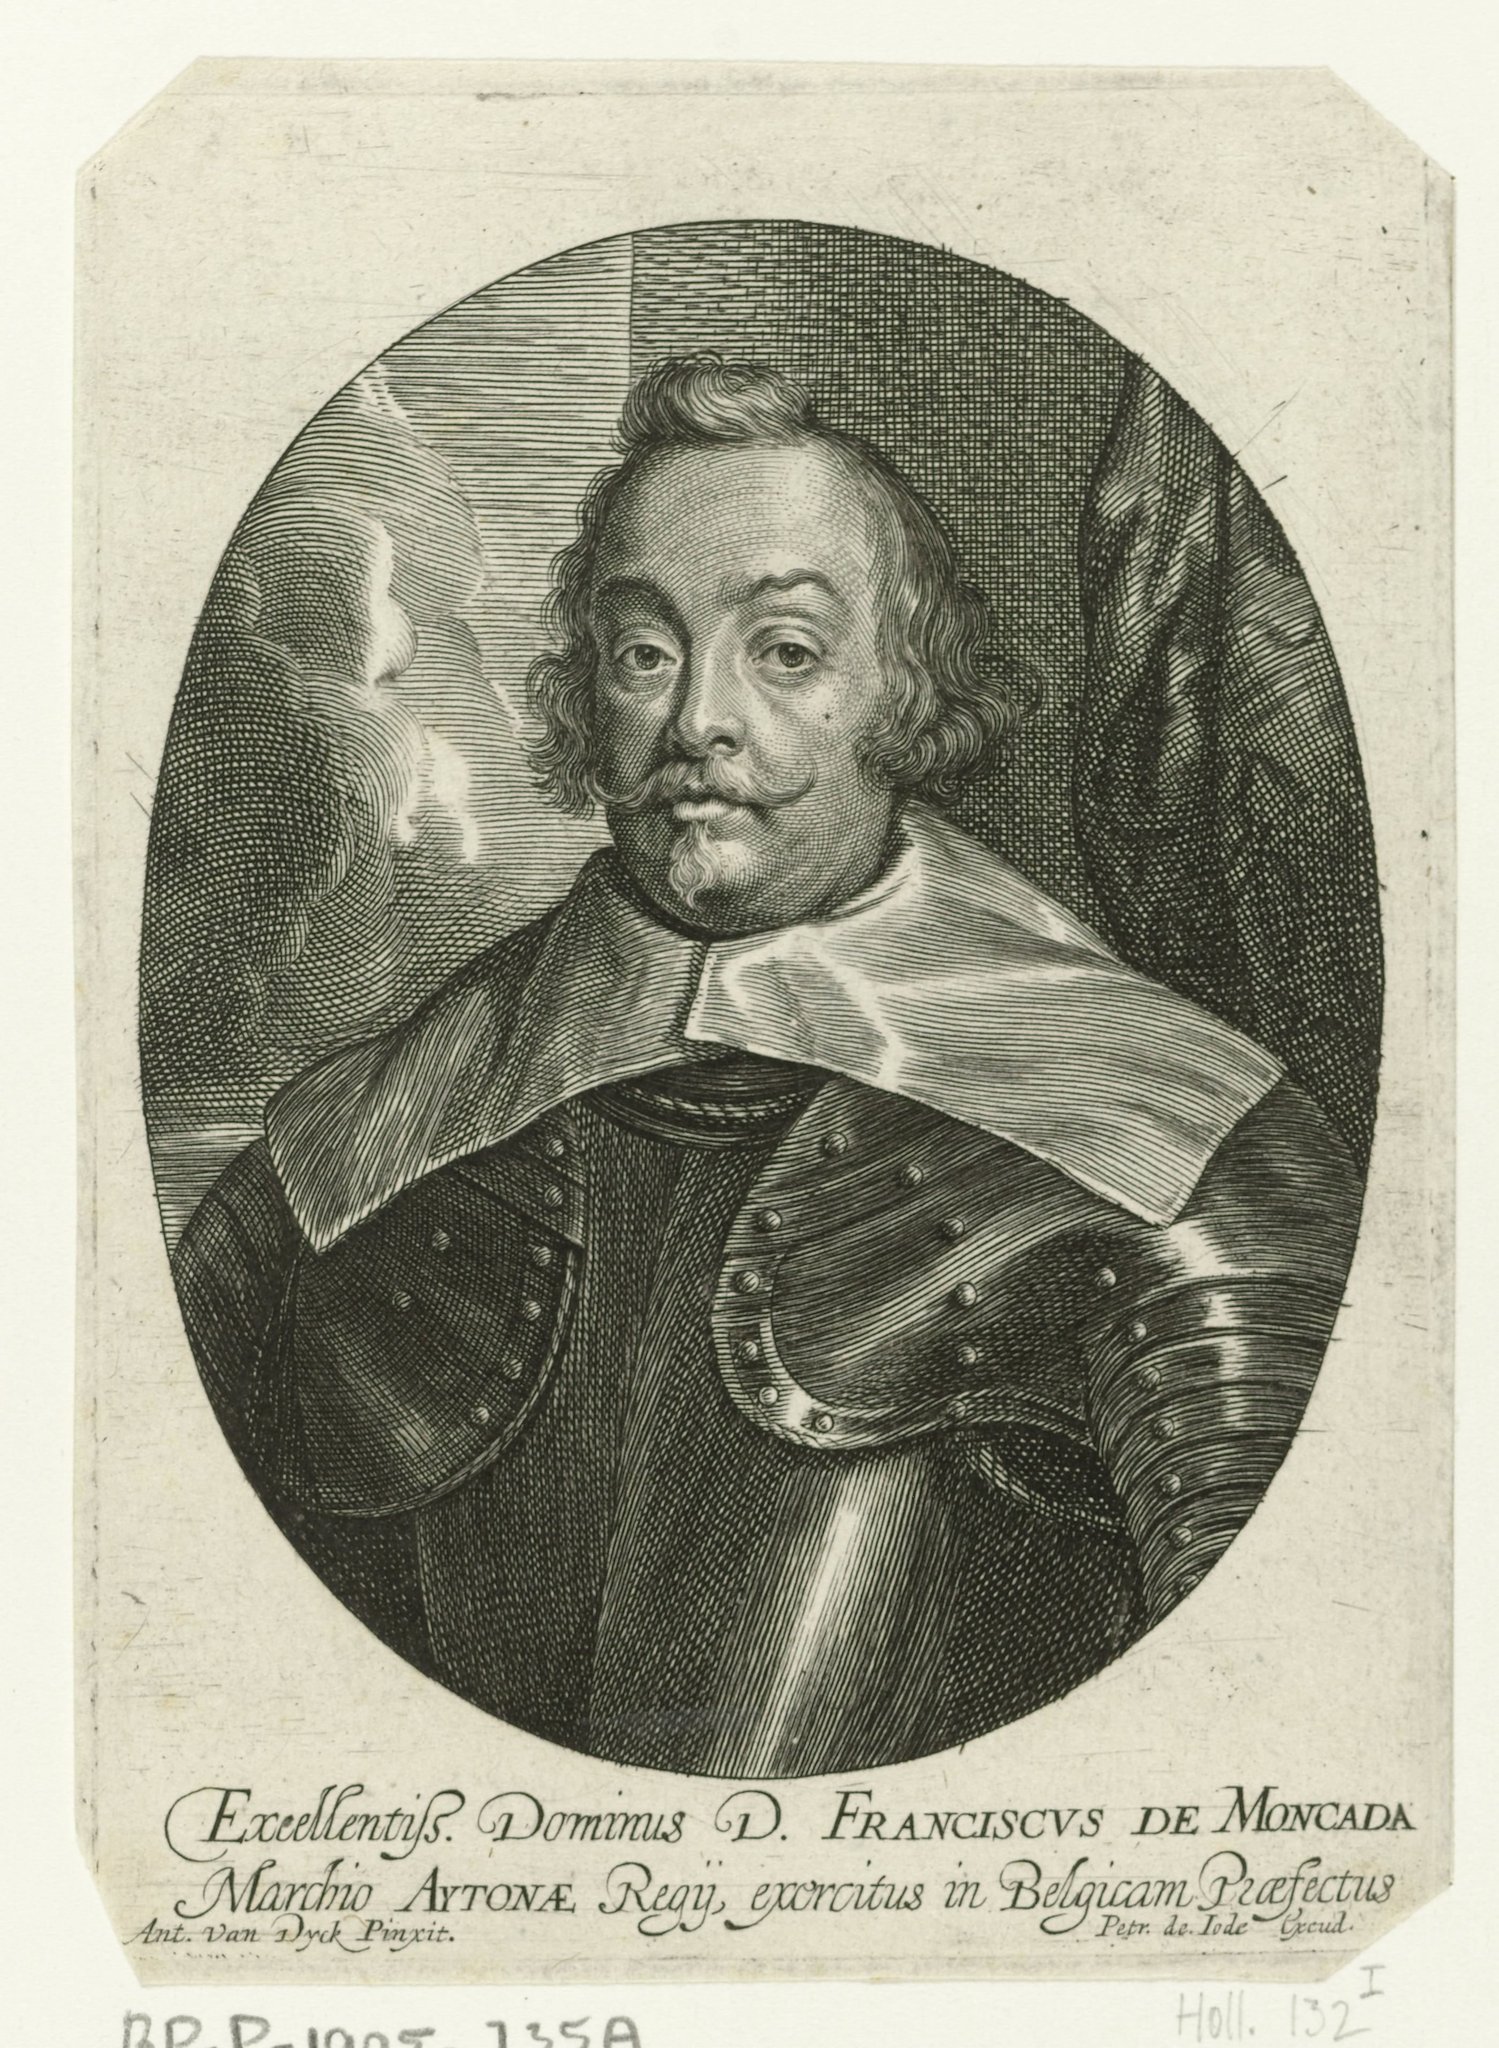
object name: print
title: Theatrum pontificum, imperatorum, regum, ducum, principum, etc.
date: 1628-1670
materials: paper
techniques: engraving, etching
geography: antwerp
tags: francisco de moncada (markies van aytona), armour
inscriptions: collector's mark: Lugt 2228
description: Busteportret van Francisco de Moncada, in harnas. Het portret is gevat in een ovaal, met een tweeregelig onderschrift in het Latijn.